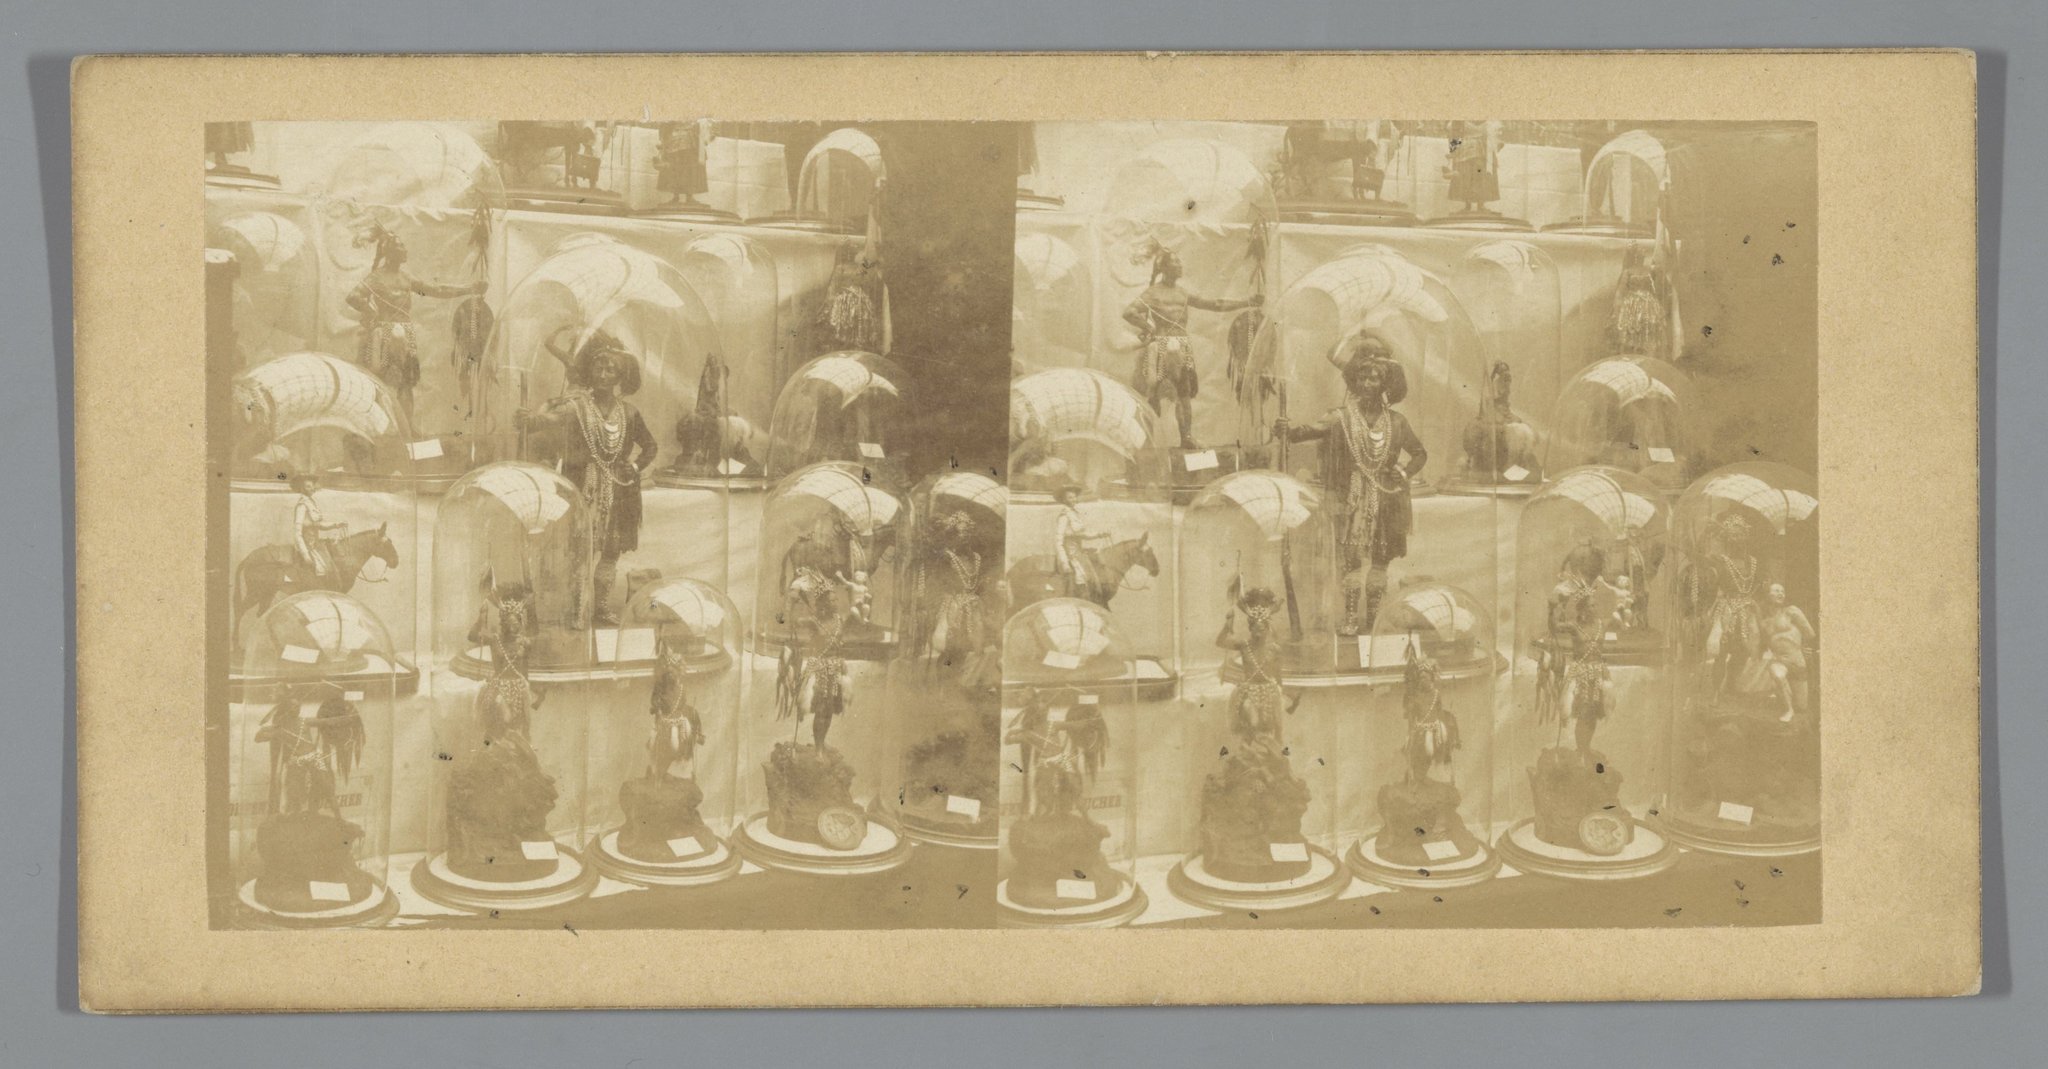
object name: stereograph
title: Vitrine met poppen van verschillende volken in een volkenkundig museum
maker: Anonymous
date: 1857-1863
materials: cardboard, paper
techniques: albumen print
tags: collection, exhibition, show